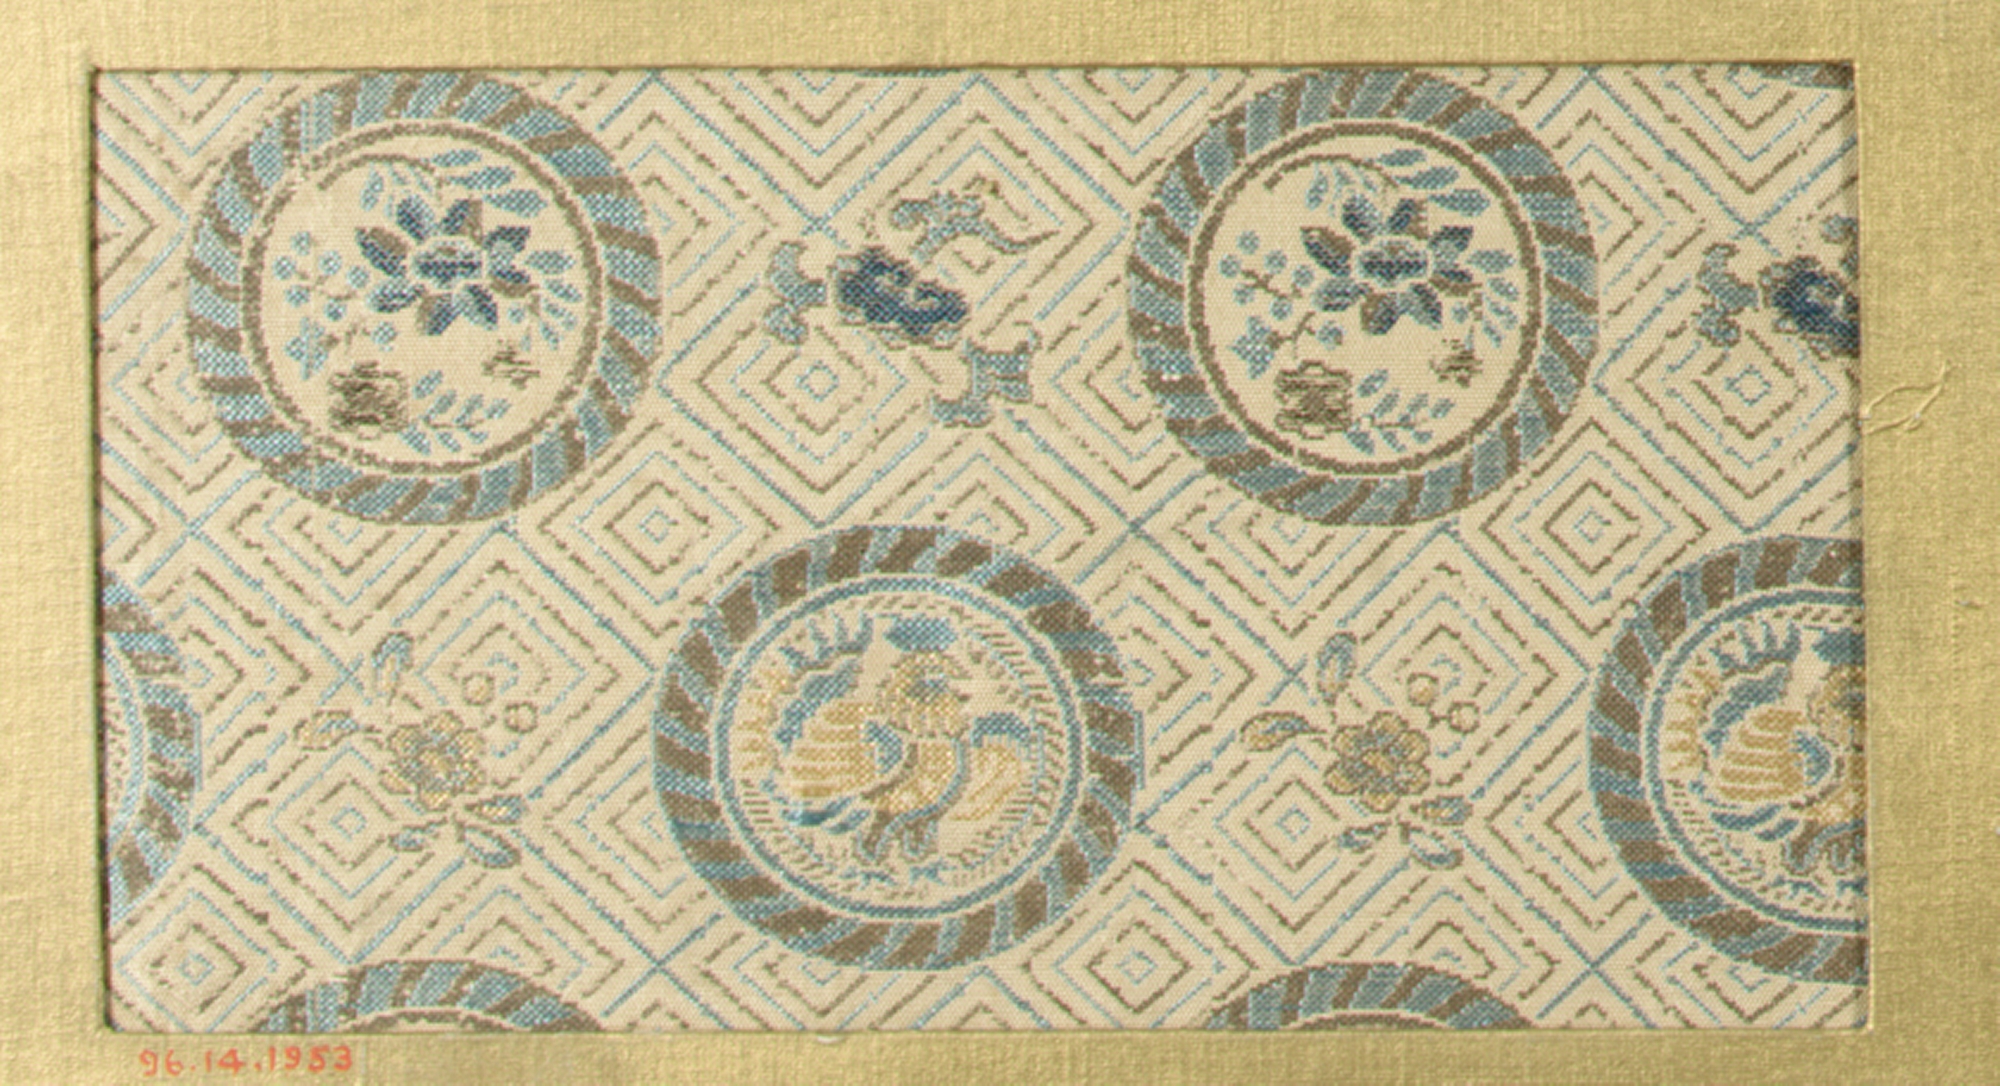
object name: piece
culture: japanese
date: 1701-1900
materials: silk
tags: birds